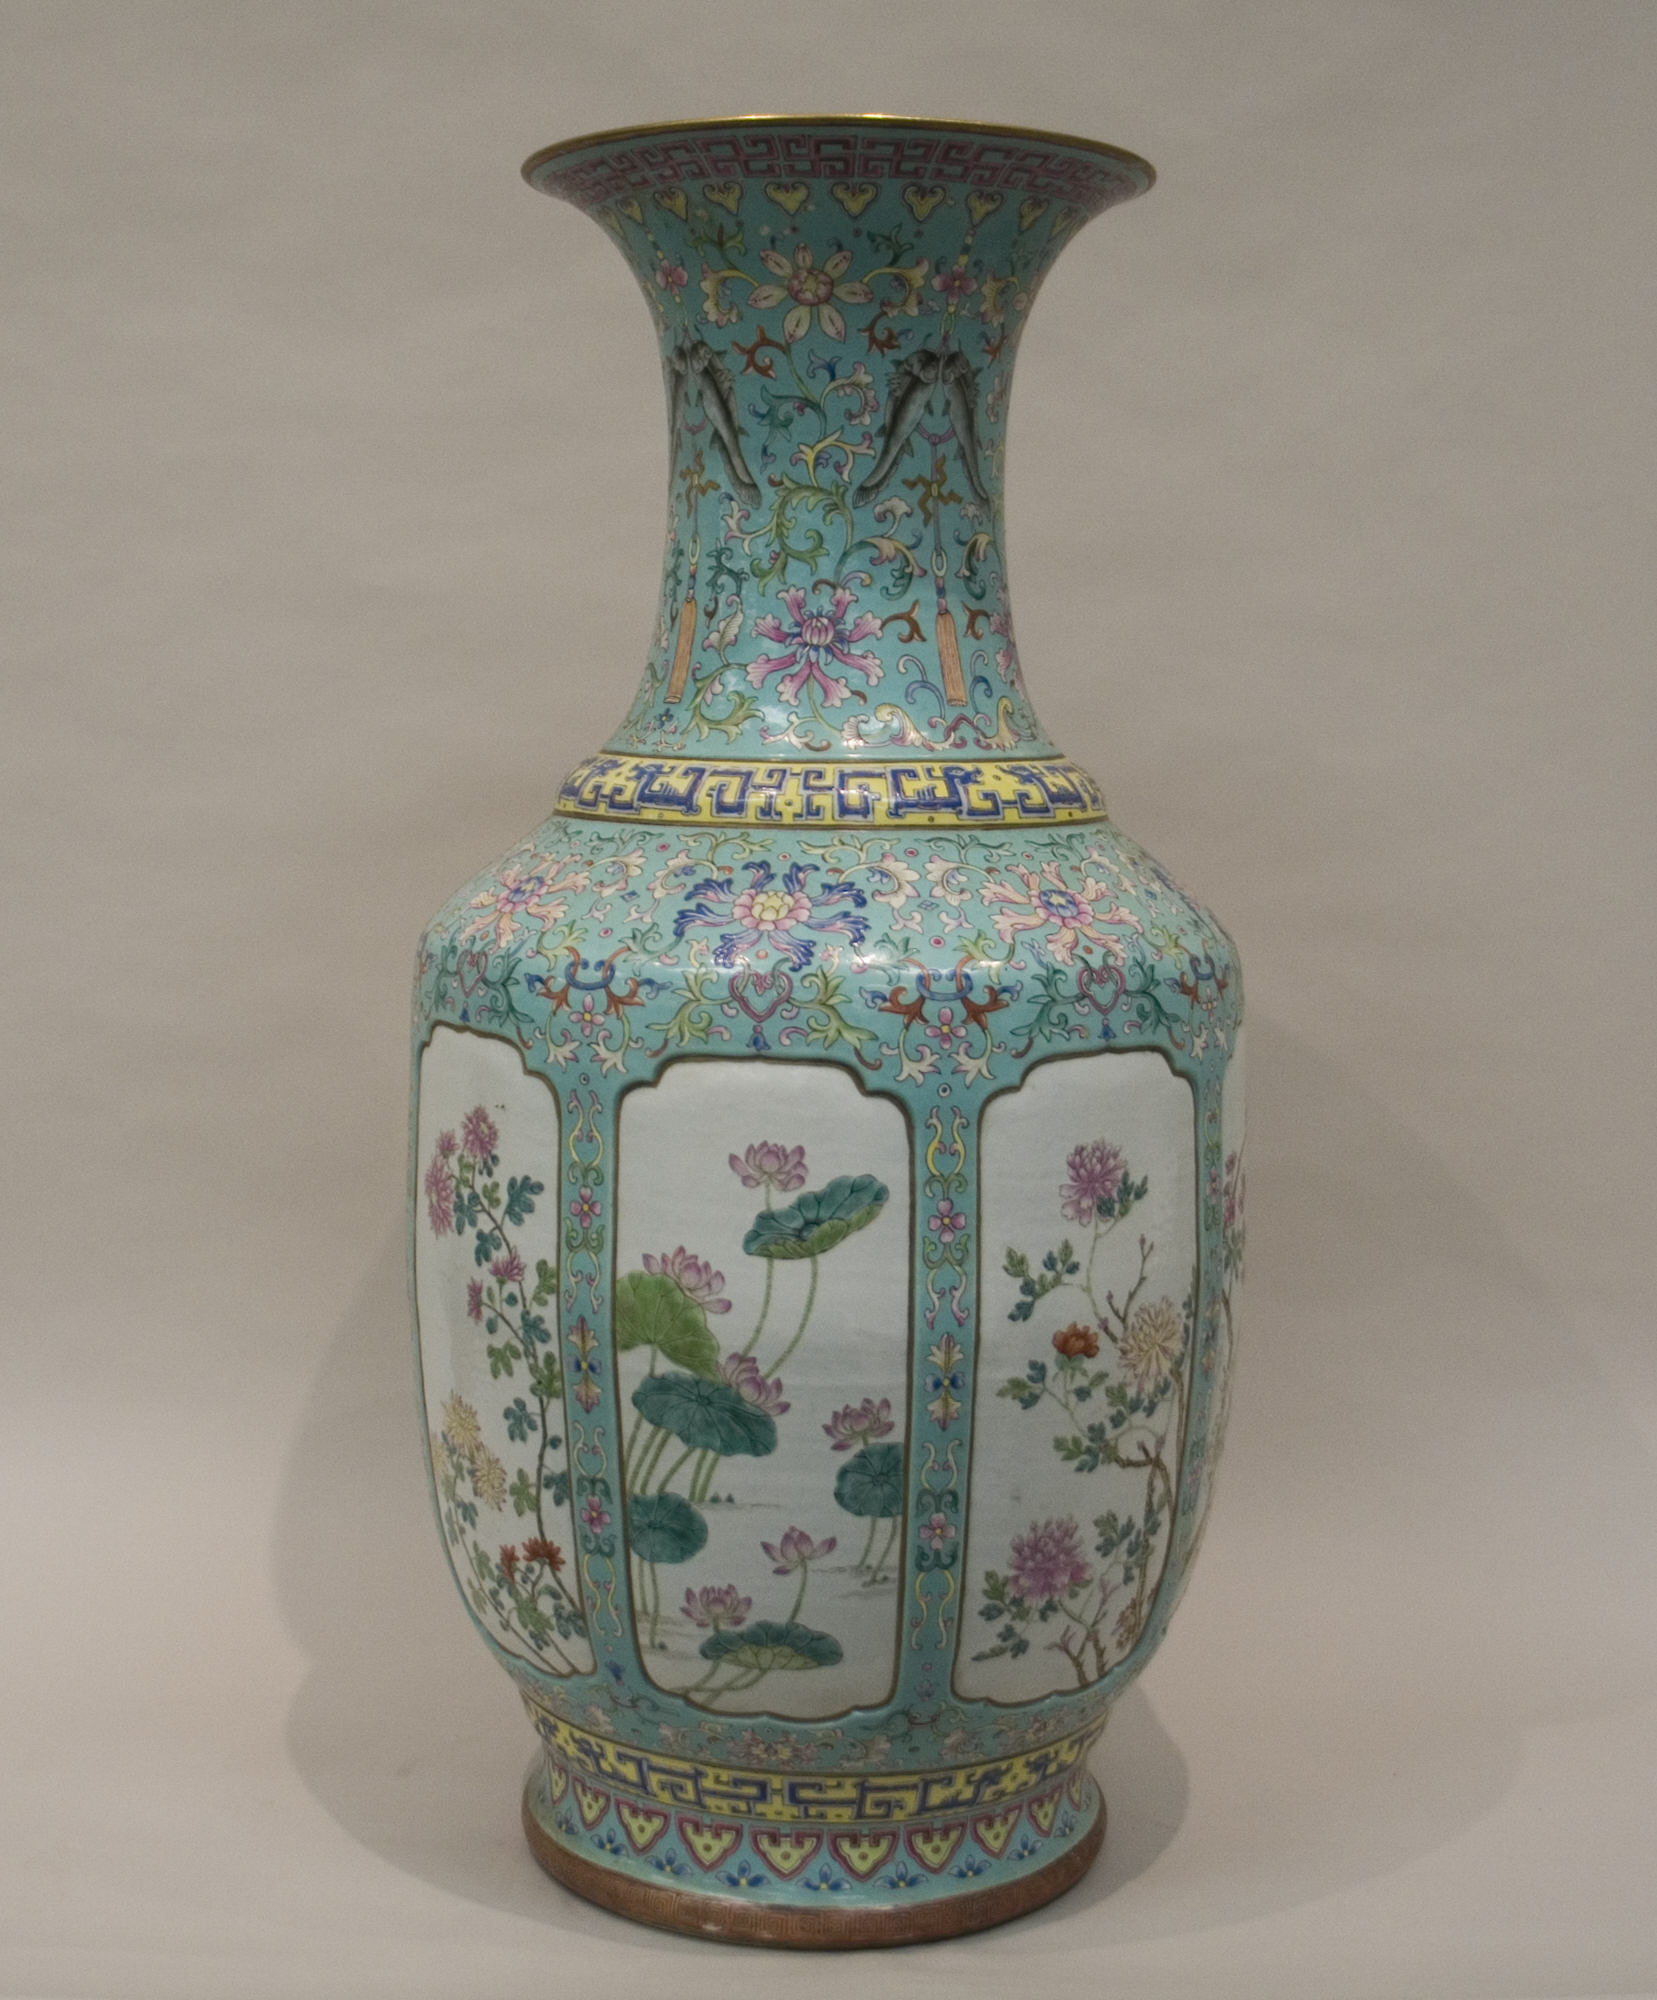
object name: vase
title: Vase decorated with lotus flowers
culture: chinese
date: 1734-1766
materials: enamel, porcelain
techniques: overglaze, painting, polychrome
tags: flowers,leaves